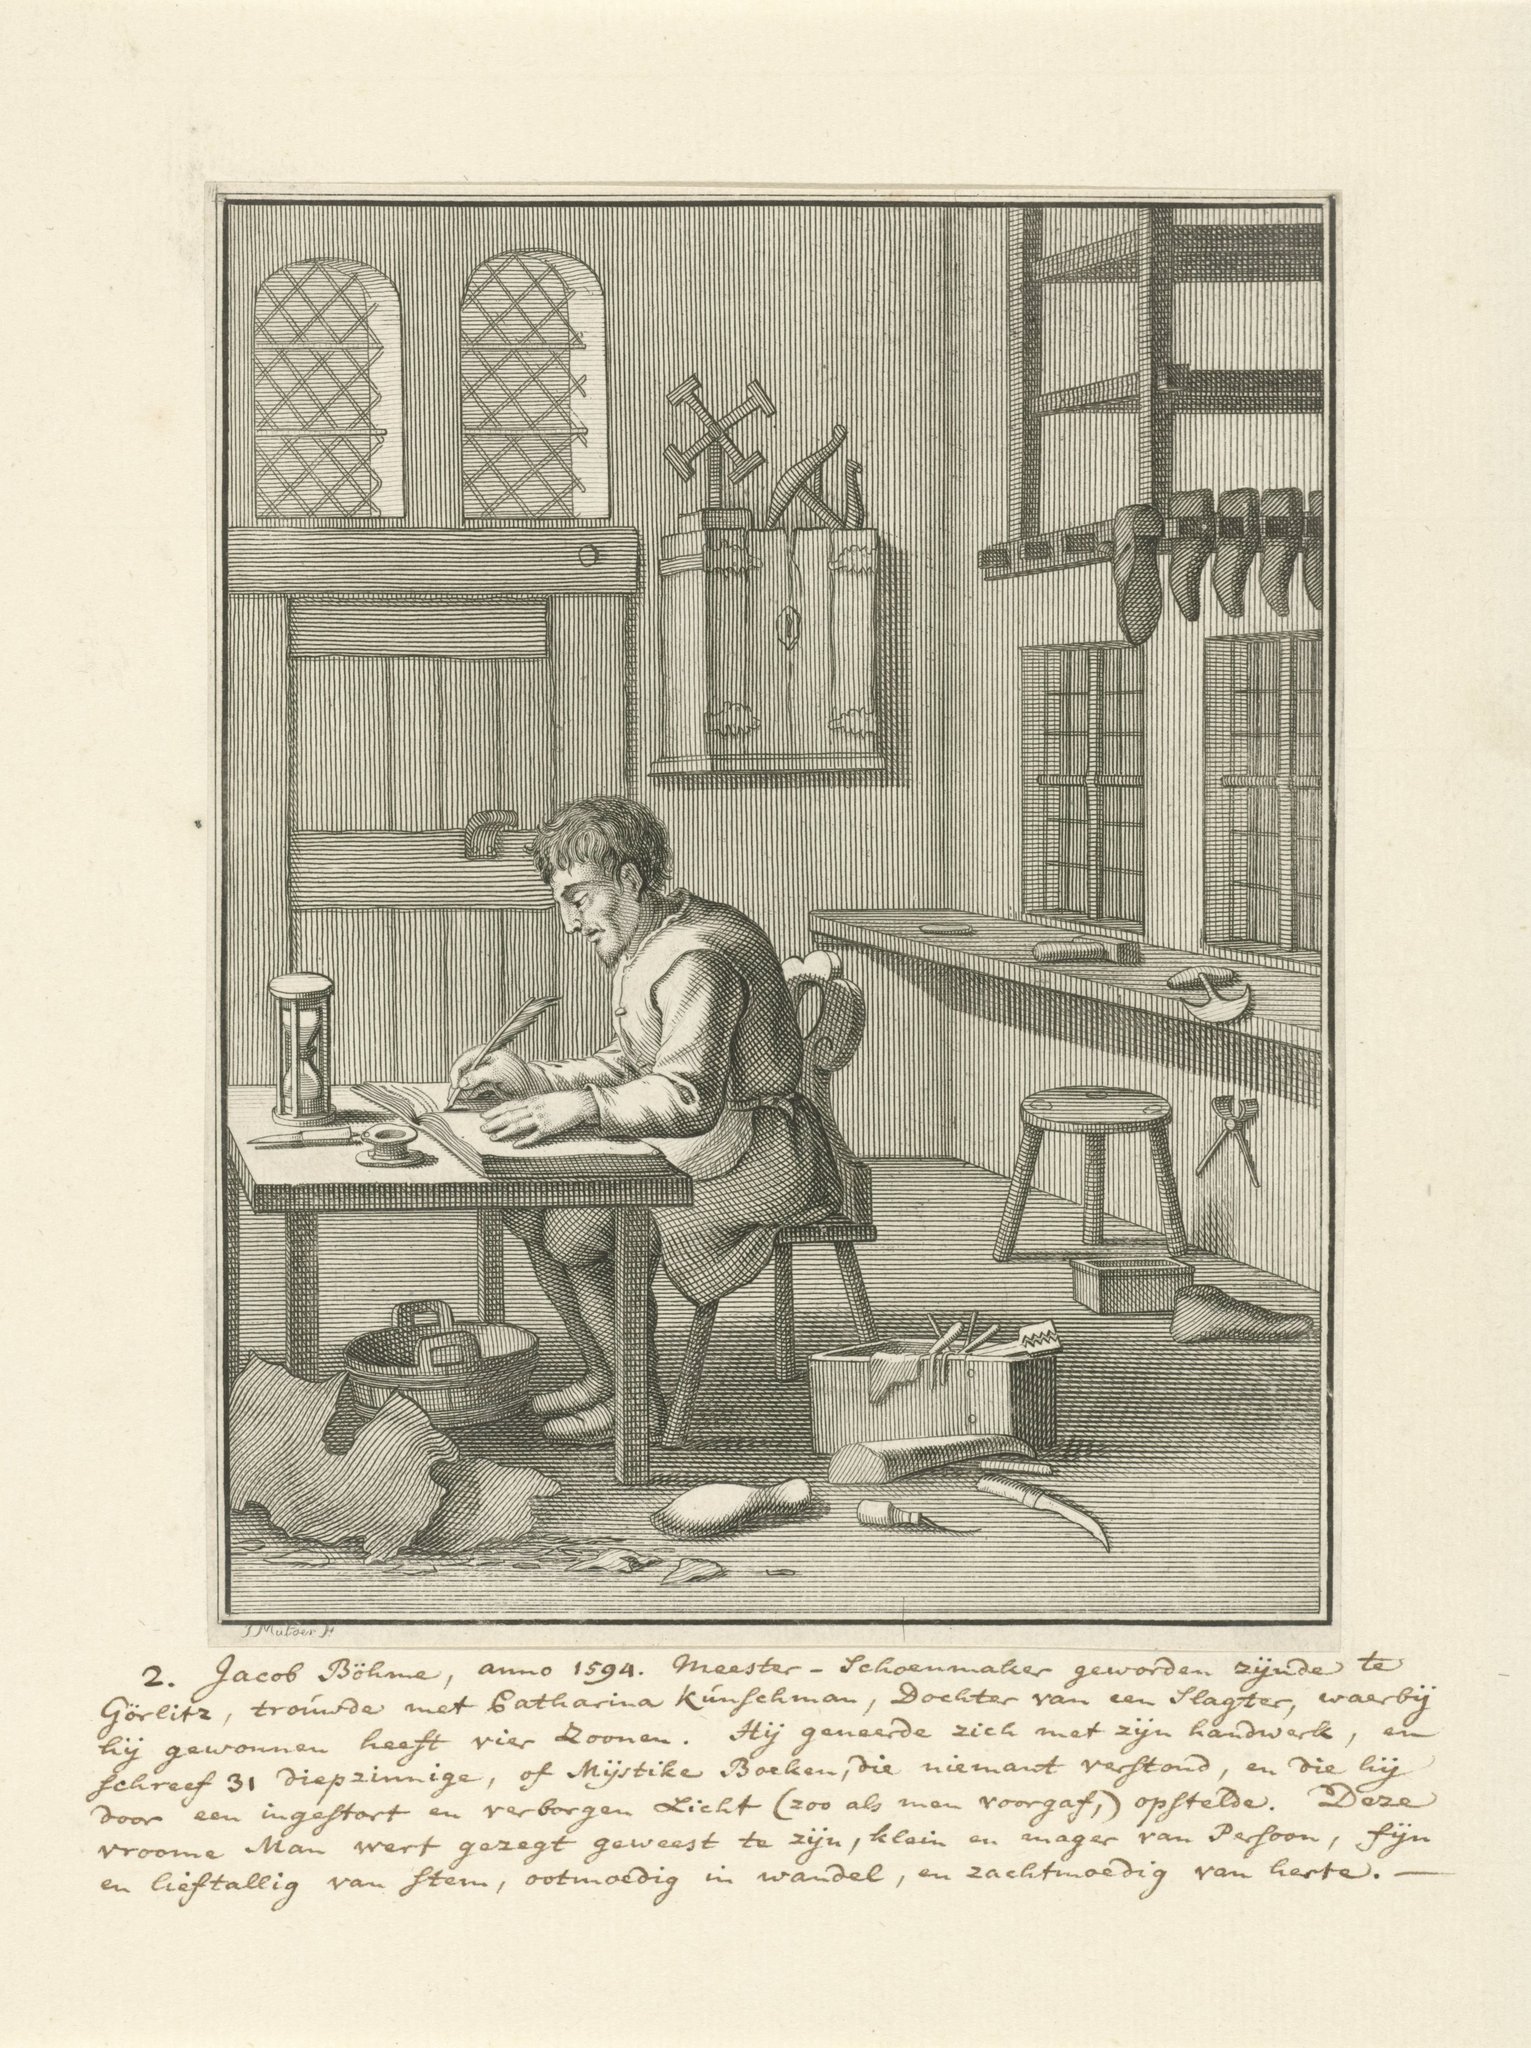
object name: book illustration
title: Jakob Böhme schrijft een van zijn boeken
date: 1686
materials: paper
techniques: engraving, etching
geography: amsterdam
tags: writing-table, writing-desk, hourglass, shoe-maker, cobbler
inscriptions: inscription: ‘2. Jacob Böhme, anno 1594. Meester-schoenmaker geworden zijnde te ... en zachtmoedig van herte.’, collector's mark: Lugt 240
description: Jakob Böhme schrijft aan een tafel in zijn schoenmakerij een boek. Op tafel een zandloper en schrijgerei. Jakob Böhme werd bekend als mysticus en theosoof.